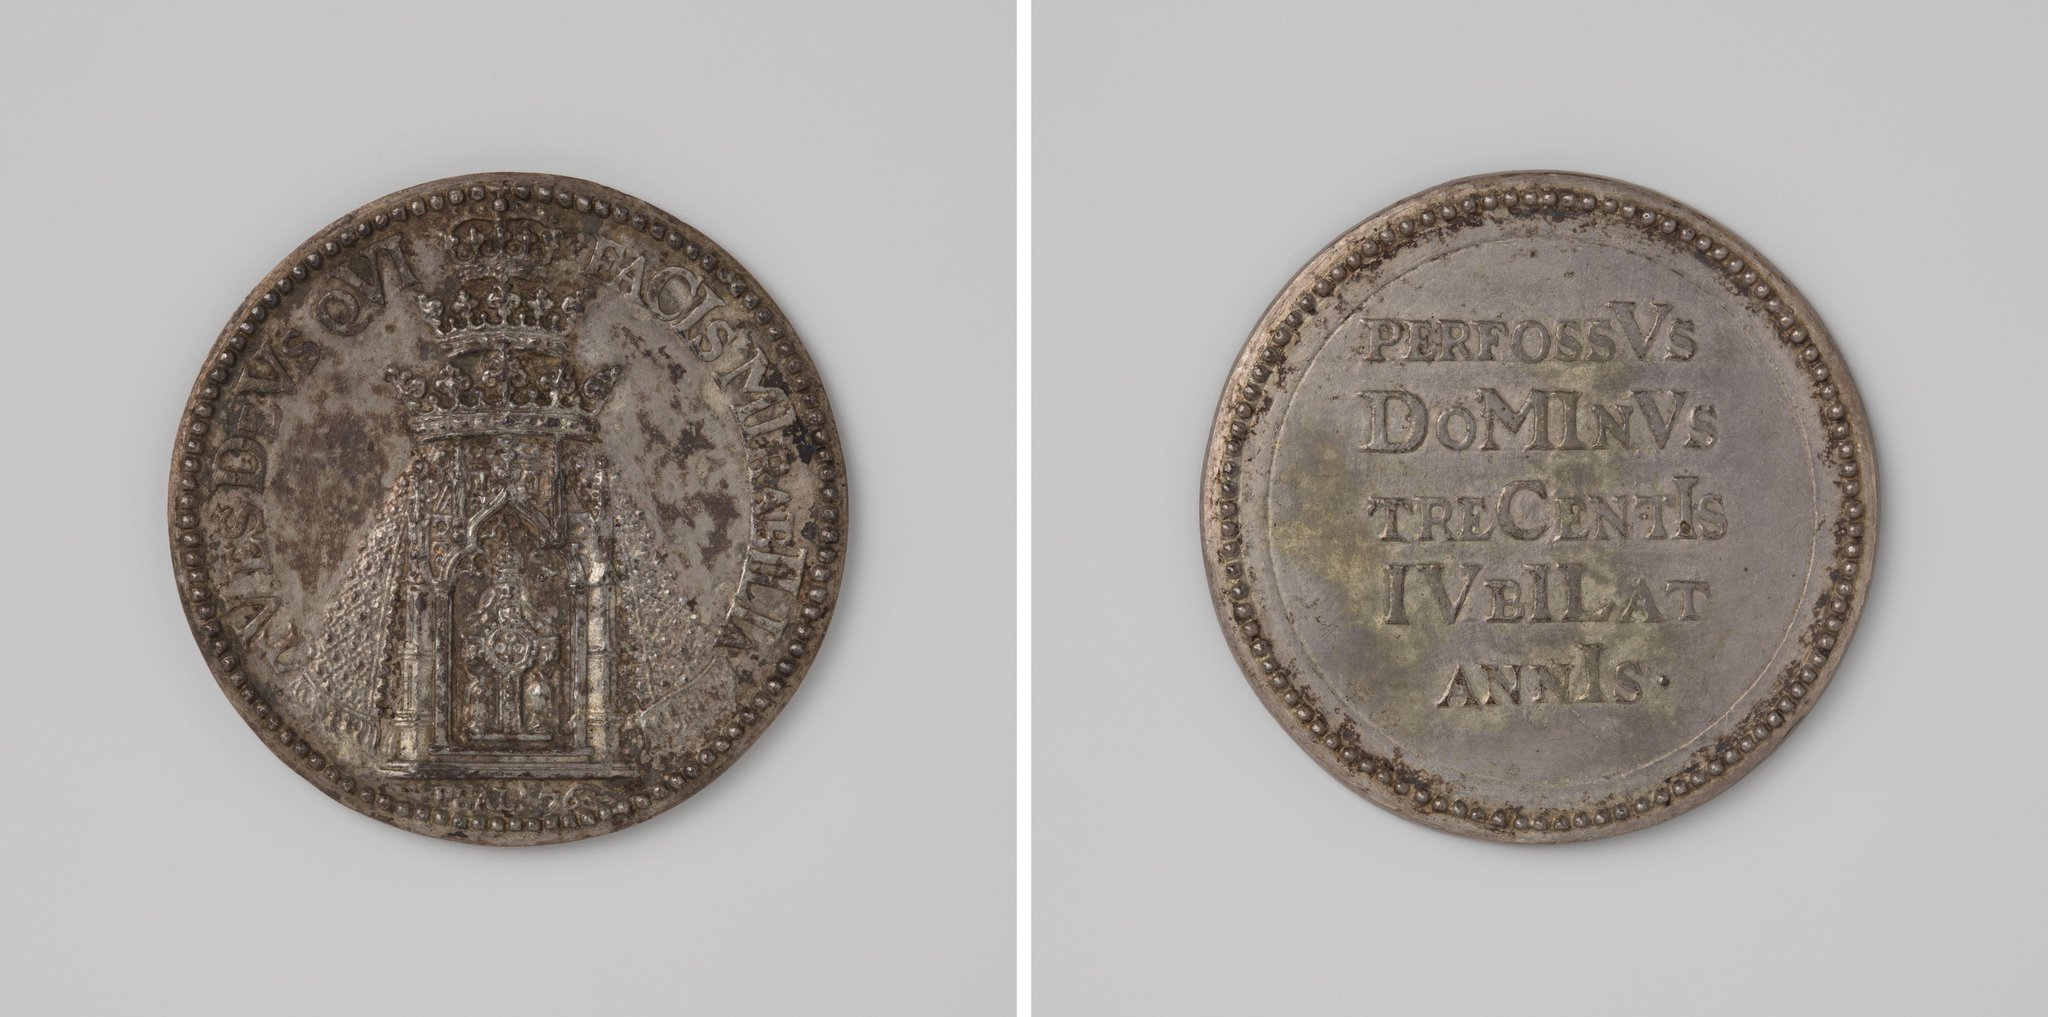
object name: history medal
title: Driehonderdjarige herdenking van het wonder van de mishandelde misbroden te Brussel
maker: Anonymous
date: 1670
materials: silver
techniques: casting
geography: brussels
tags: brussels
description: Zilveren penning. Voorzijde: met drie kronen gekroond tabernakel waarin drie hosties ten toon gesteld worden binnen omschrift. Keerzijde: opschrift